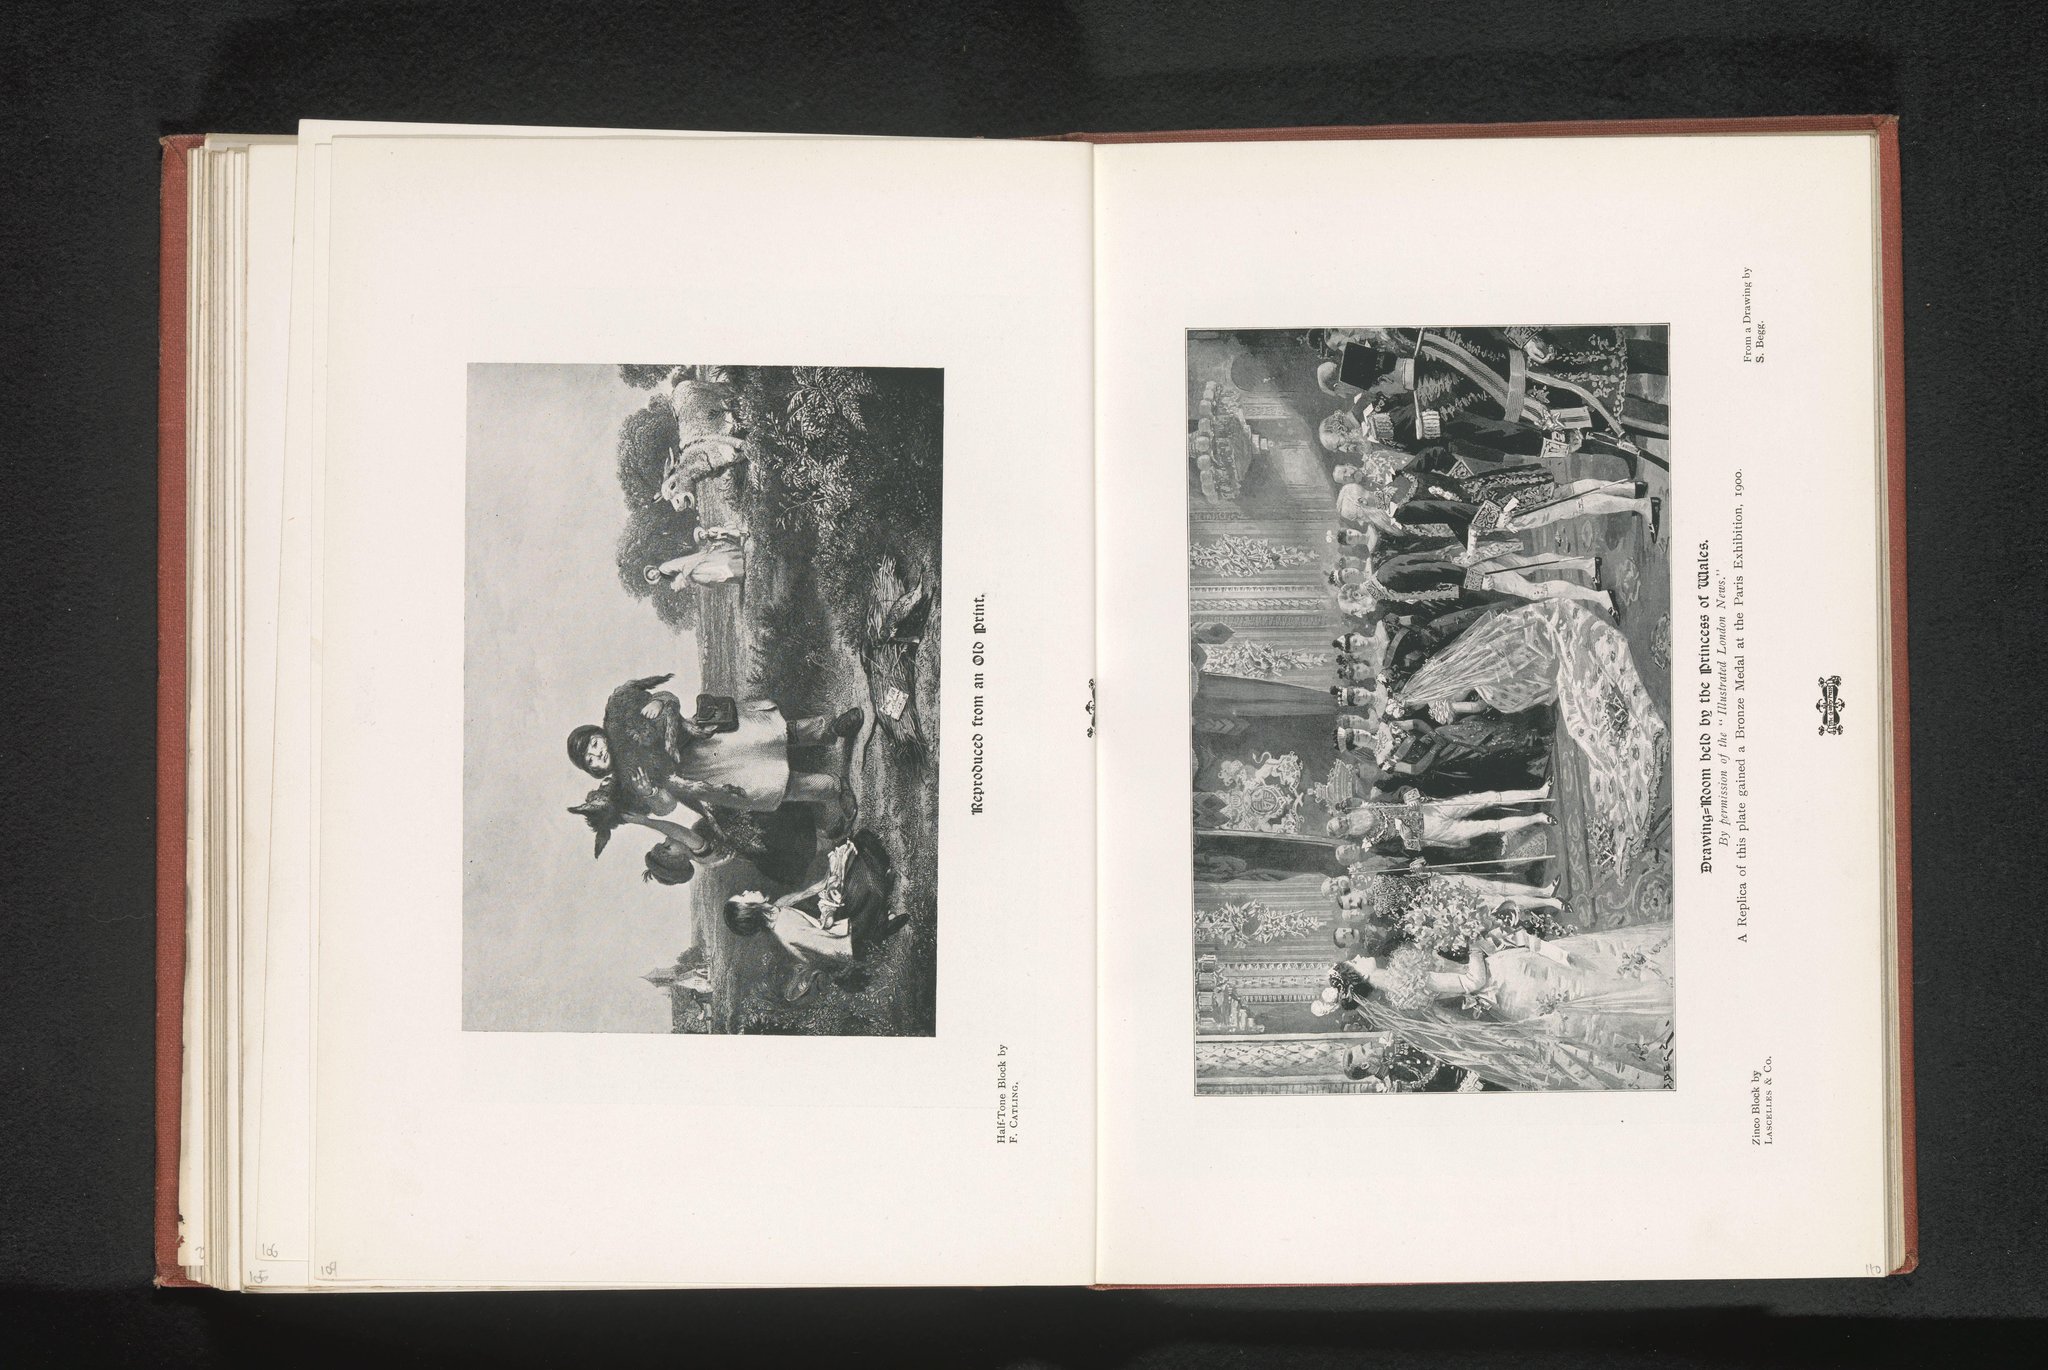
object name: page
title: Reproductie van een tekening van een ceremonie met Mary van Teck door S. Begg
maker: s. begg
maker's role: artist, draughtsman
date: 1895-1900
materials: paper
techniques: autotype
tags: princess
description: Prent op vijfde ongenummerde pagina na pagina 88.